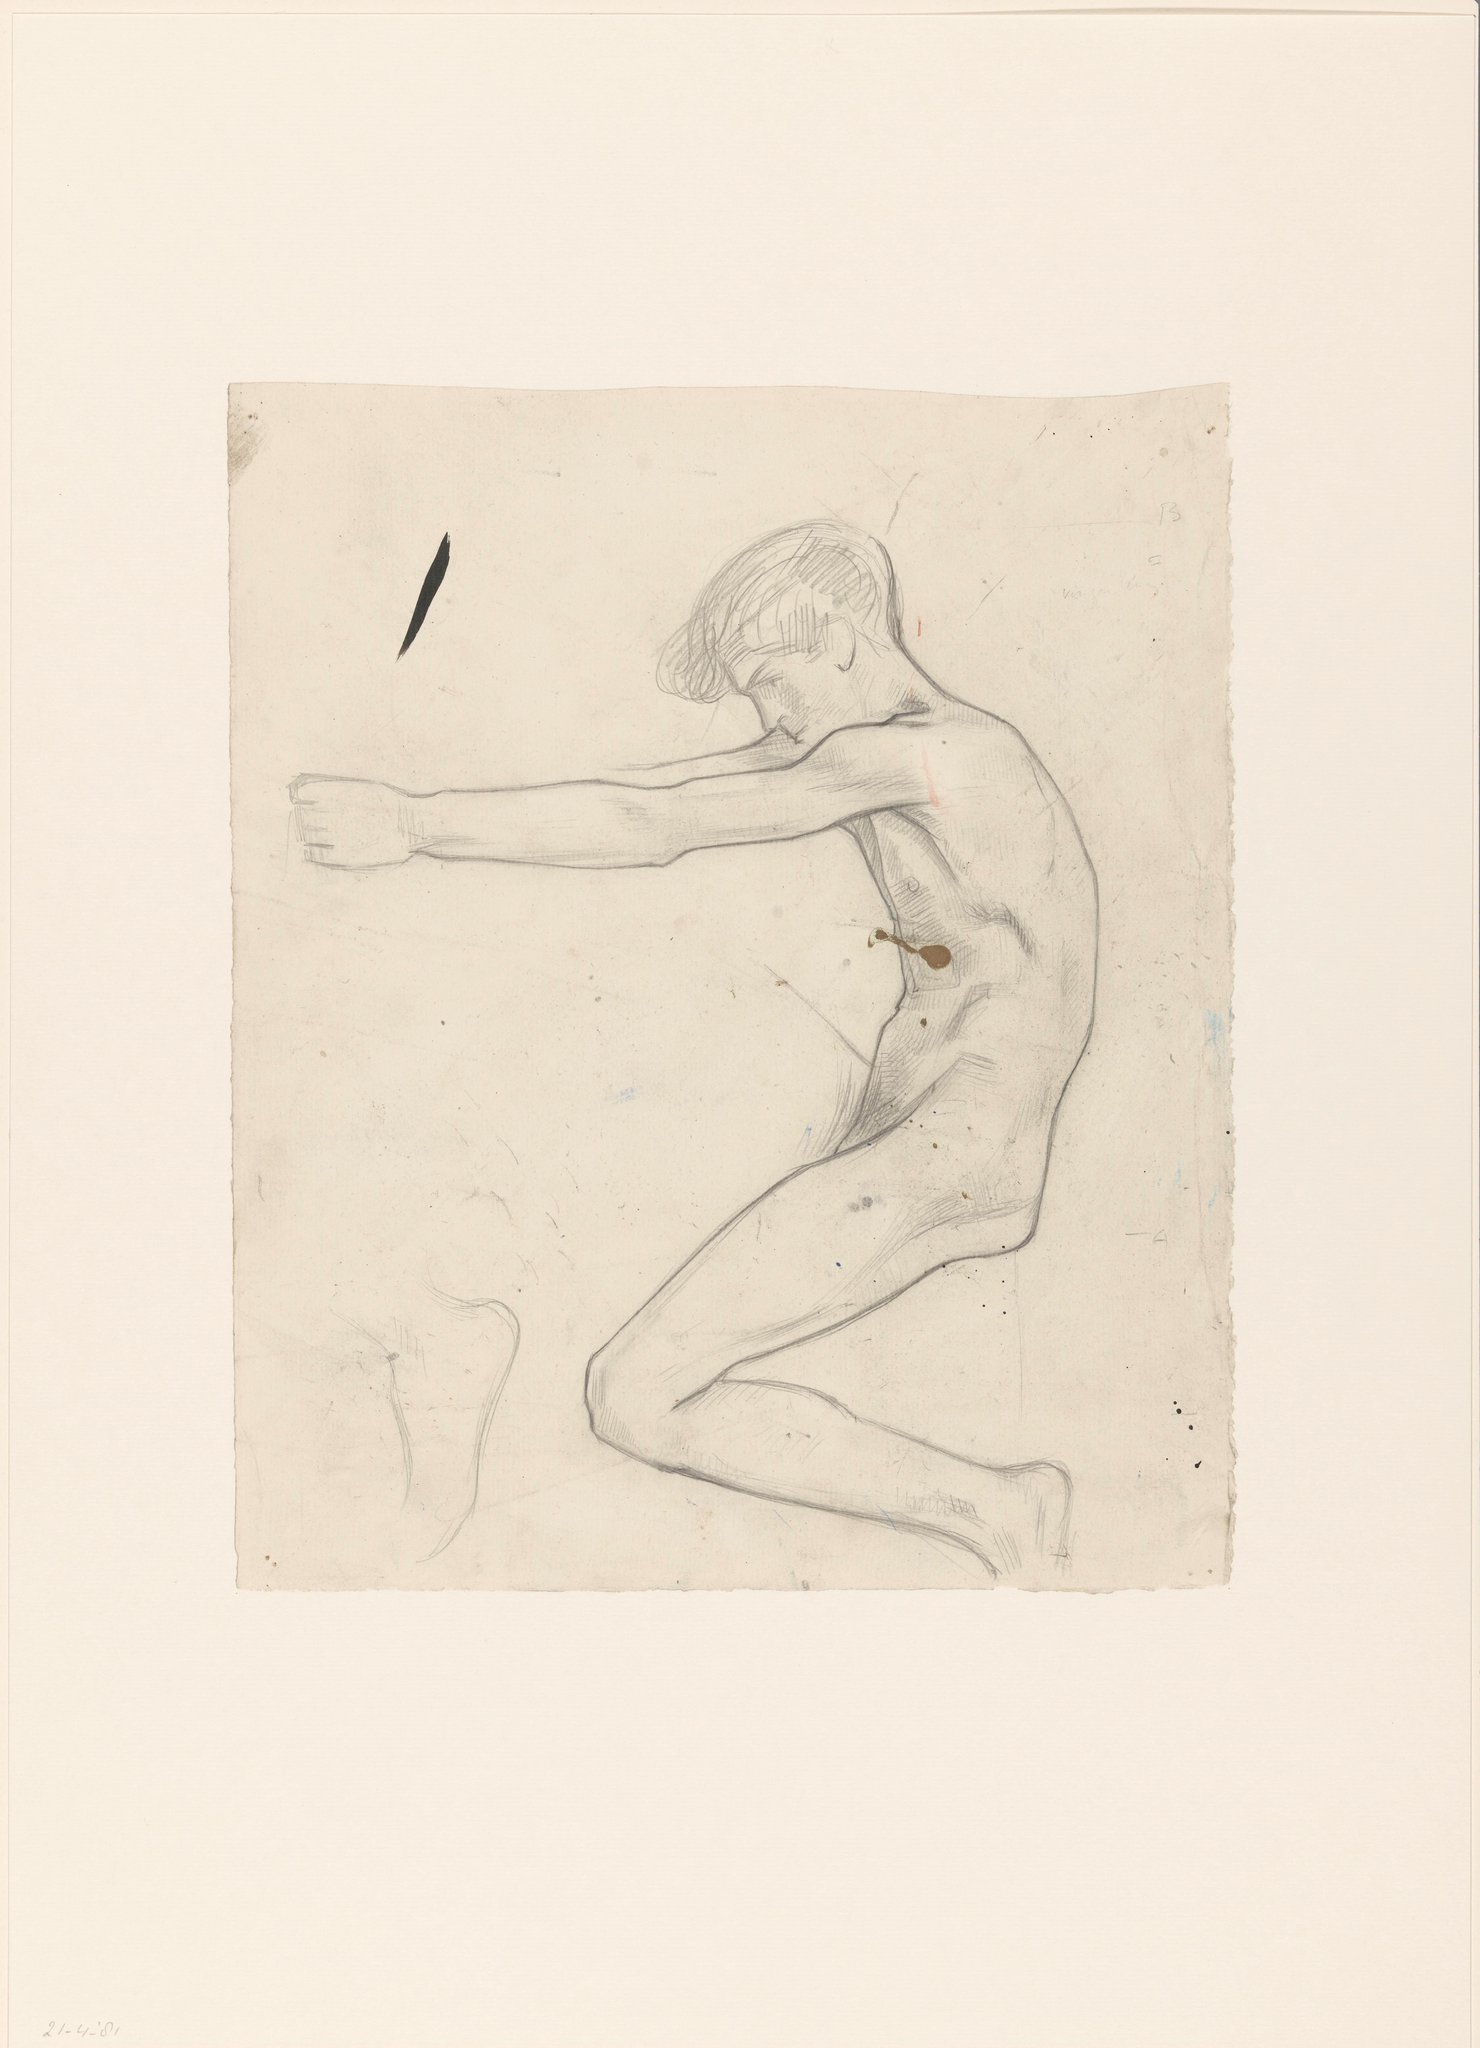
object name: drawing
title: Zittende naakte jongen met naar voren gestrekte armen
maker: richard nicolaüs roland holst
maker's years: 1868-1938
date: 1878-1938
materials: paper, pencil